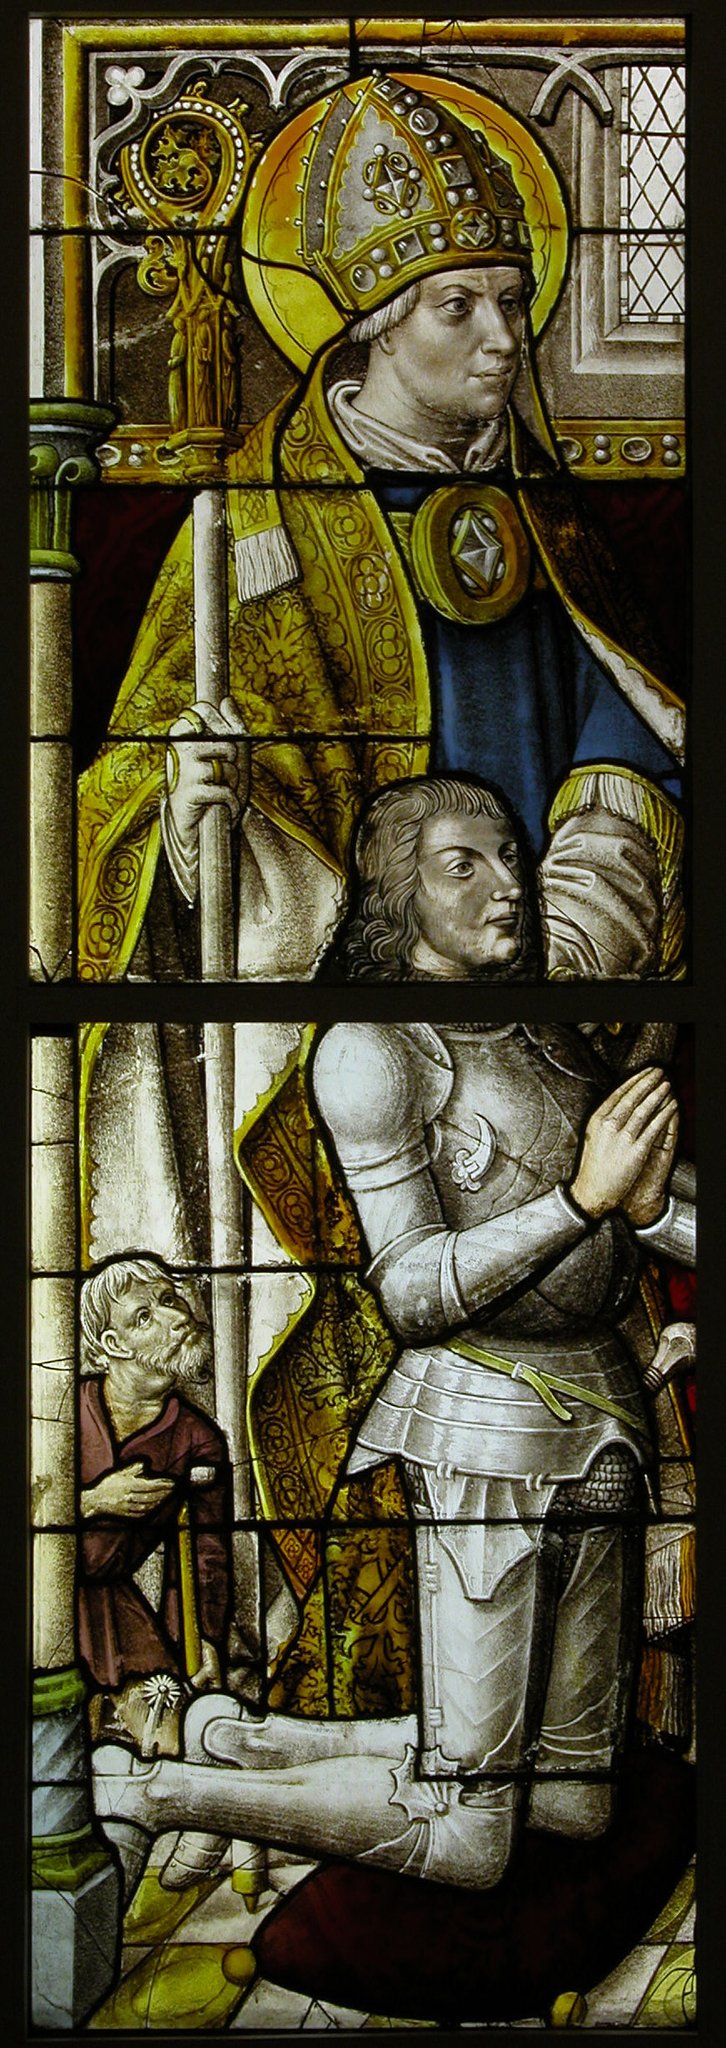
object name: panel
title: Stained Glass Panel with a Knight and His Patron Saint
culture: german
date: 1505-1508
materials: glass, metal, paint, pigment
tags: men,knights